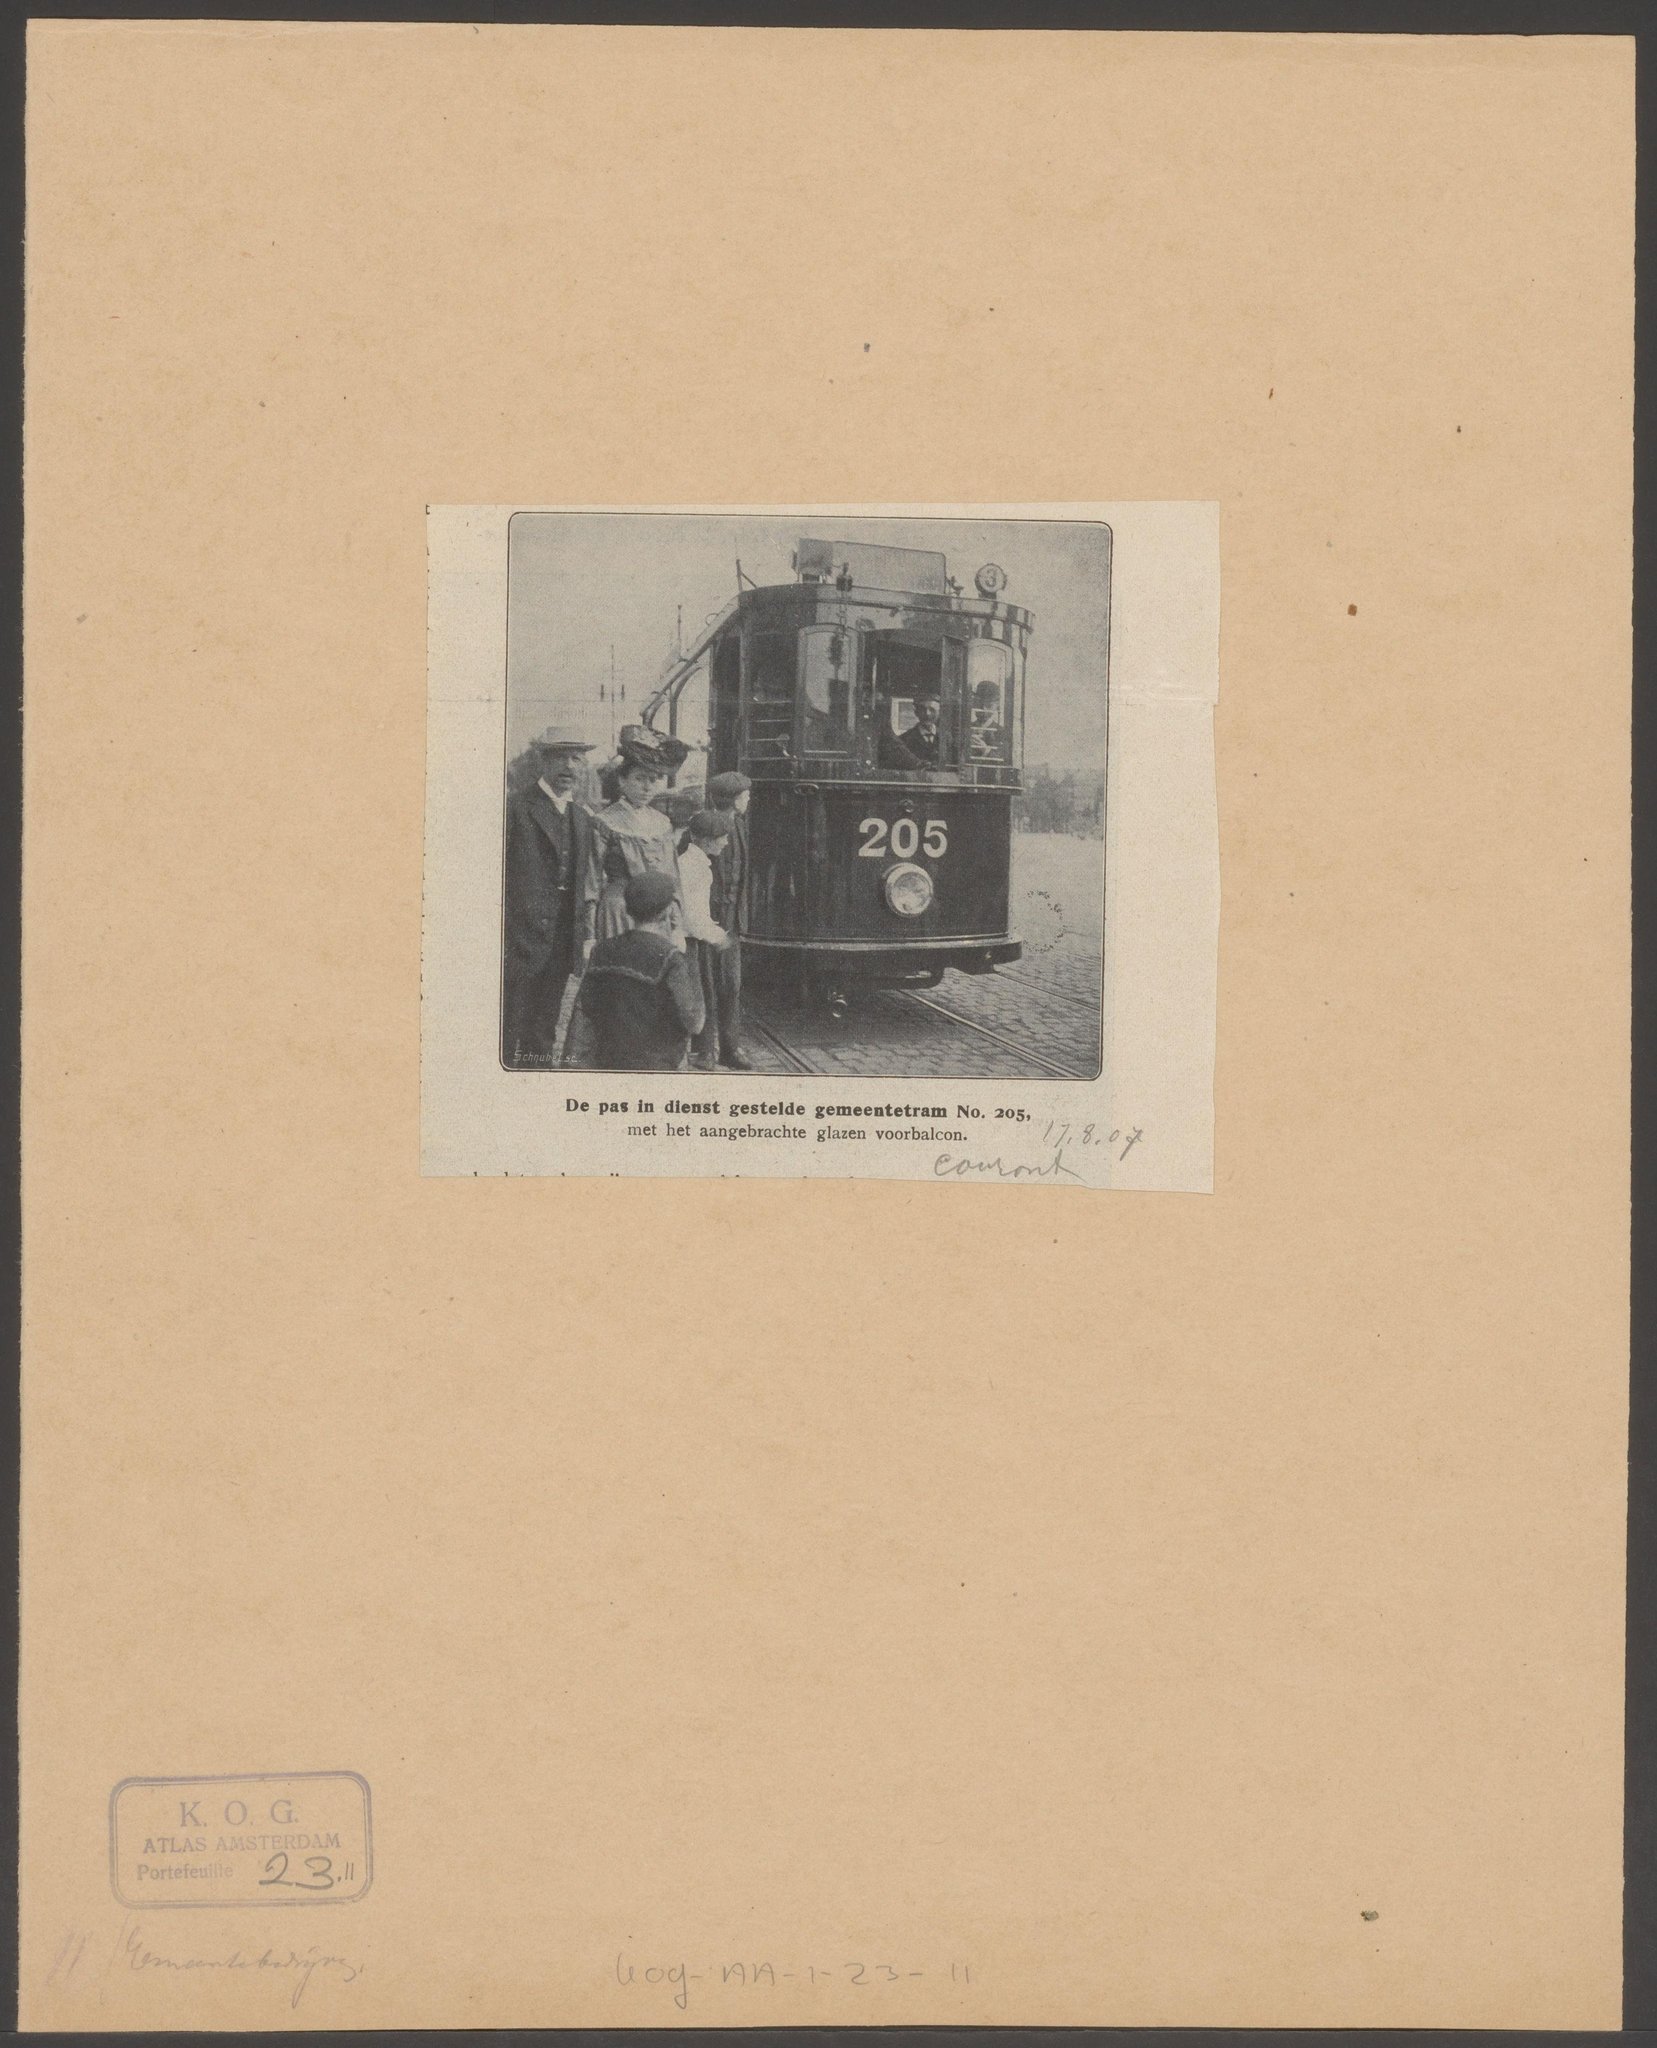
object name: photomechanical print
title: Tram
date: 1907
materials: paper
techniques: letterpress printing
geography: amsterdam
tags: tram, amsterdam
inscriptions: collector's mark: Lugt 1641b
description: Prent mogelijk uit: De Amsterdamsche Courant, 17 augustus 1907.